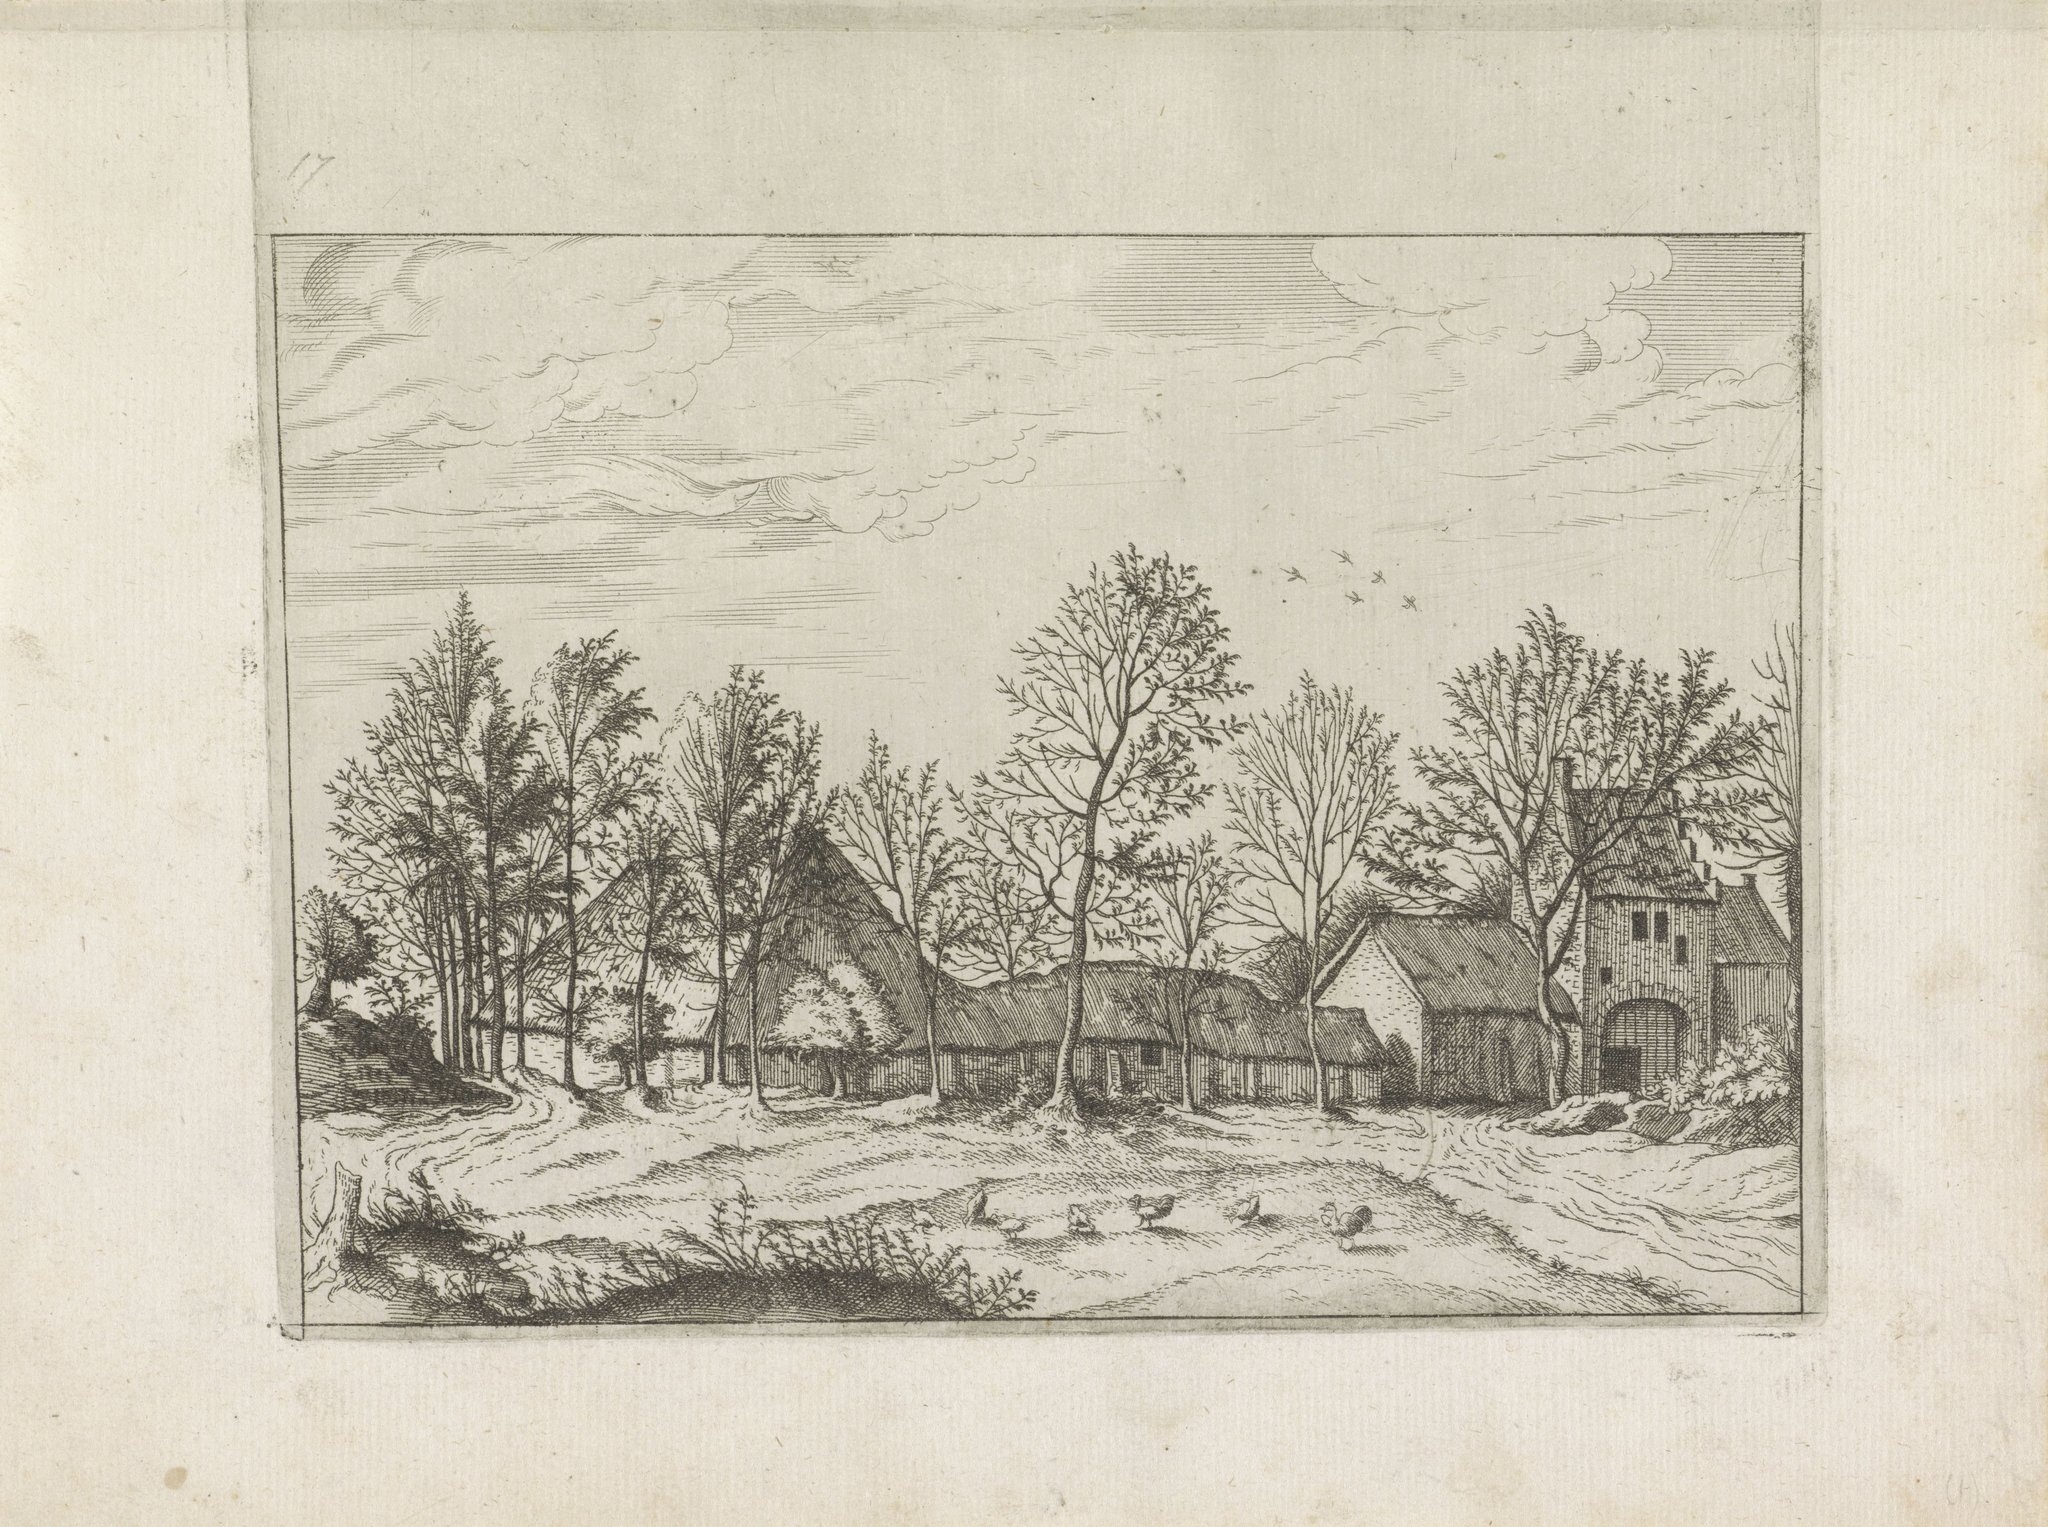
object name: print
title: Kleine landschappen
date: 1559-1561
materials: paper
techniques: etching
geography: antwerp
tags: gate, entrance, farm (building)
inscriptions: collector's mark: Lugt 2228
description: Links een boerderij omringd door bomen. Rechts een poortgebouw.